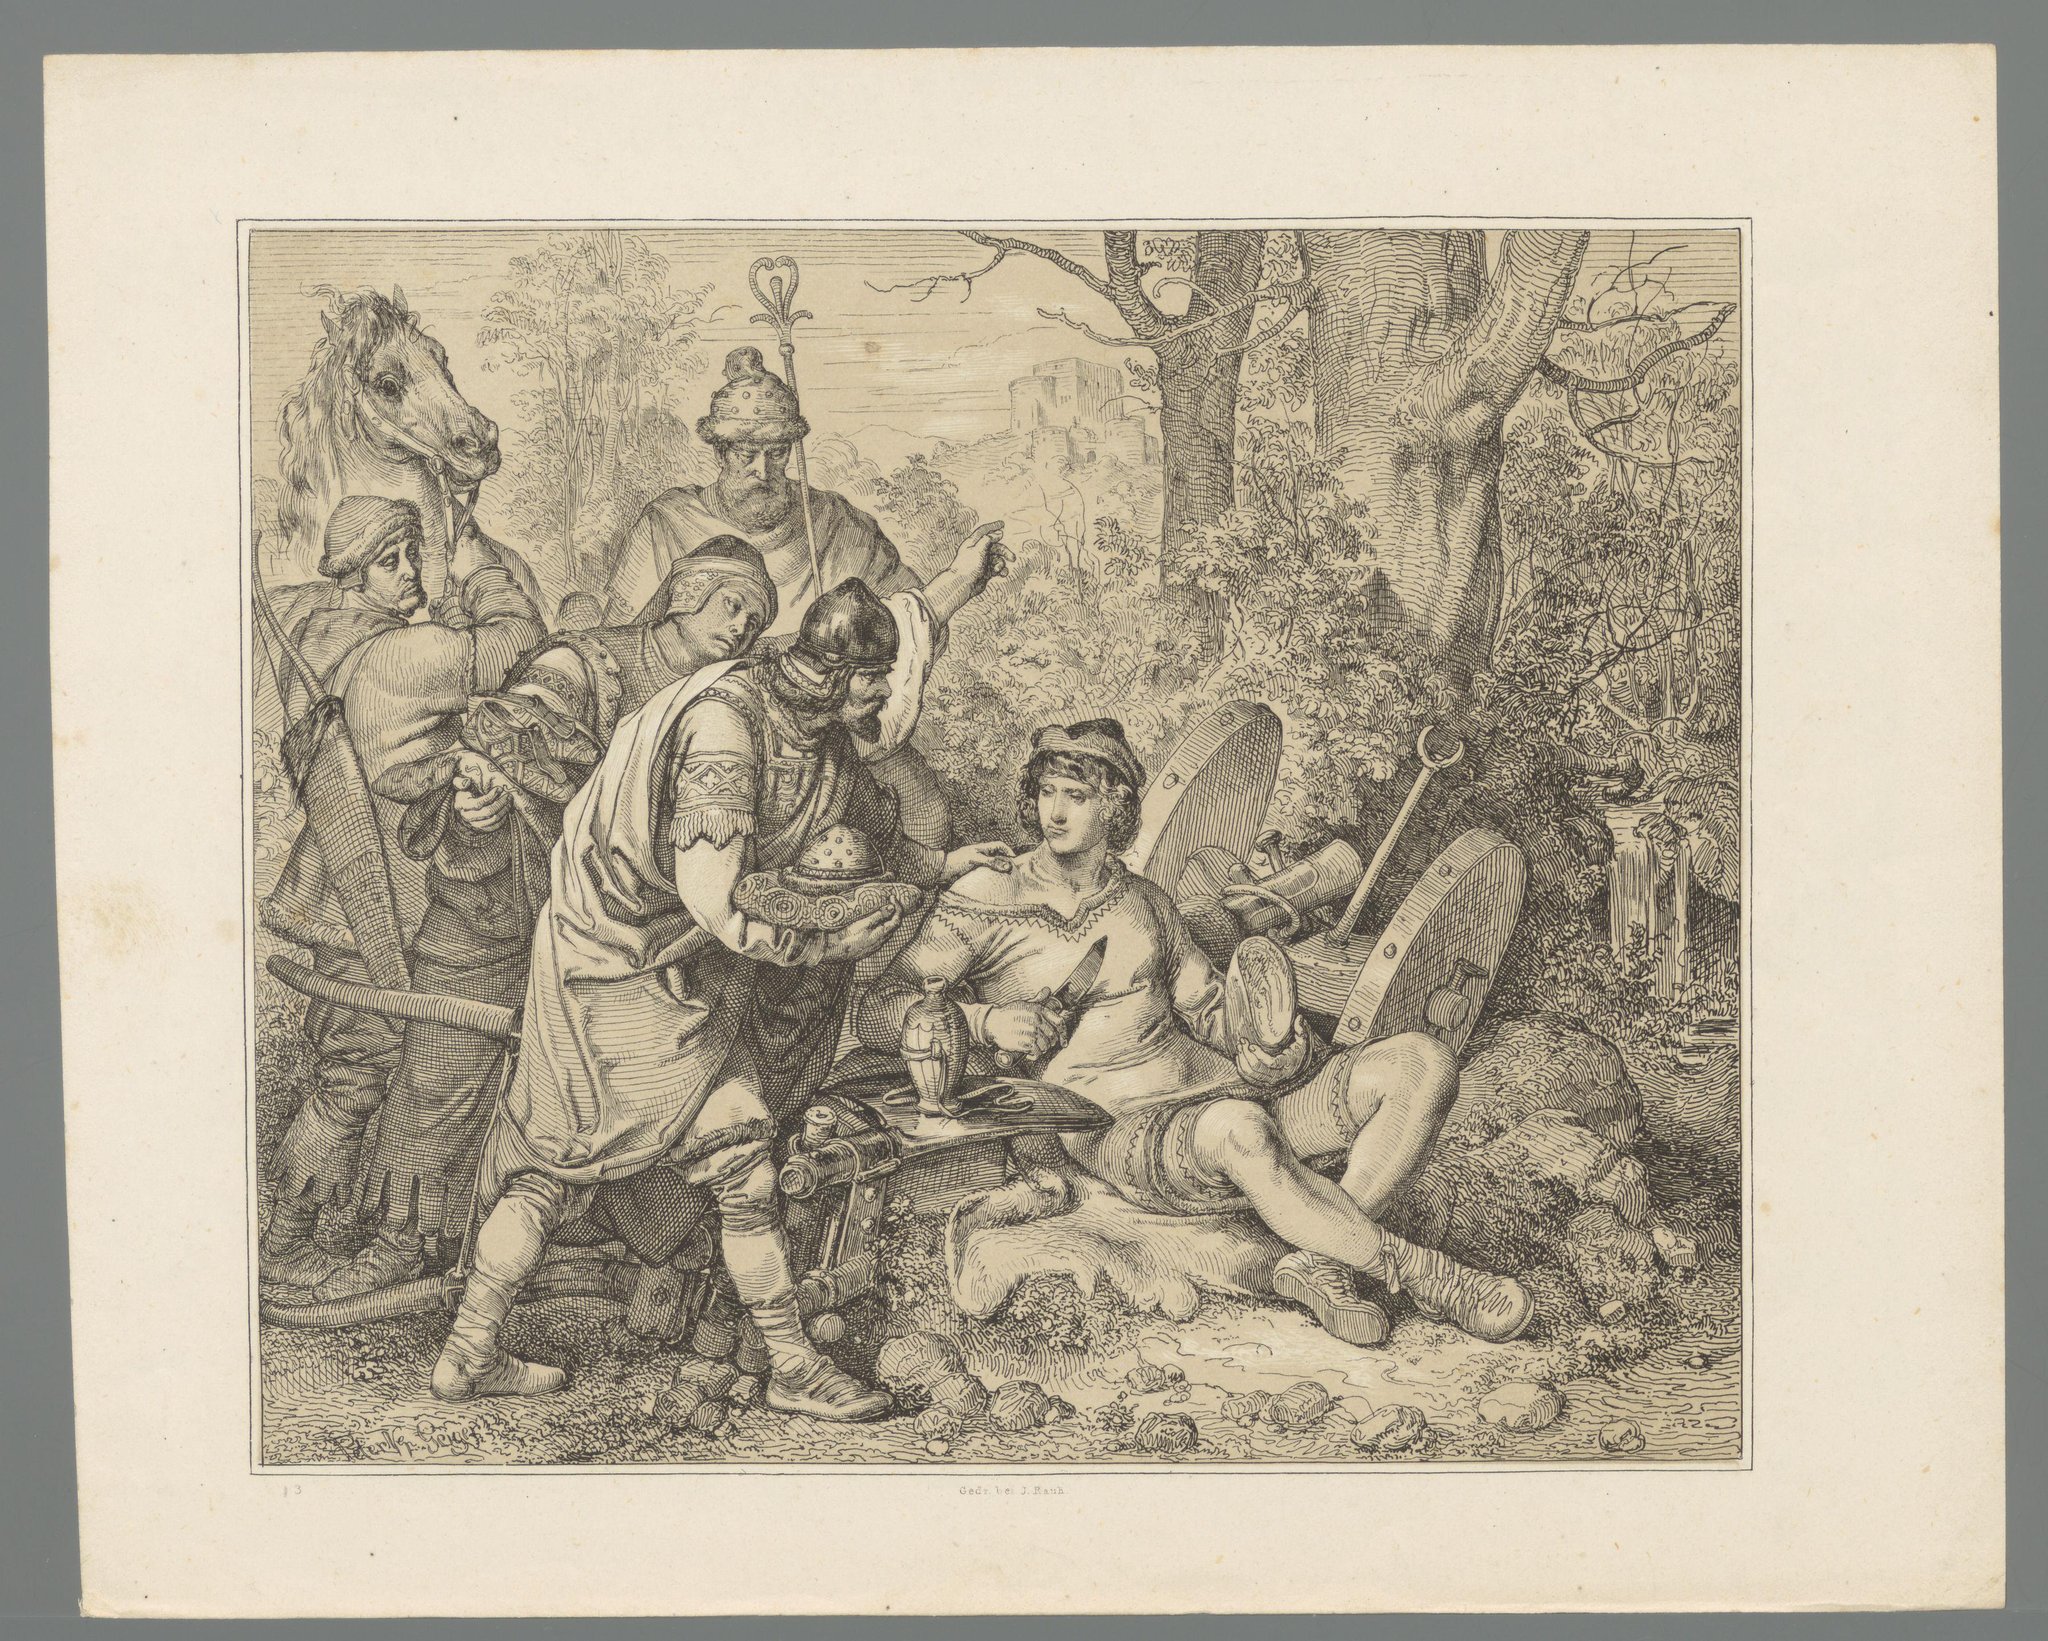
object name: print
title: Mannen brengen een jongeman in een bos kleding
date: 1840-1845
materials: paper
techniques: tone lithography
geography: vienna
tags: adult man (+ five persons), forest, wood, clothes, costume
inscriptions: collector's mark: Lugt 2228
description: Prent maakt deel uit van een serie met historische taferelen. Over deze serie is verder niets bekend. Het betreft mogelijk scènes uit het leven van een koning/heilige.